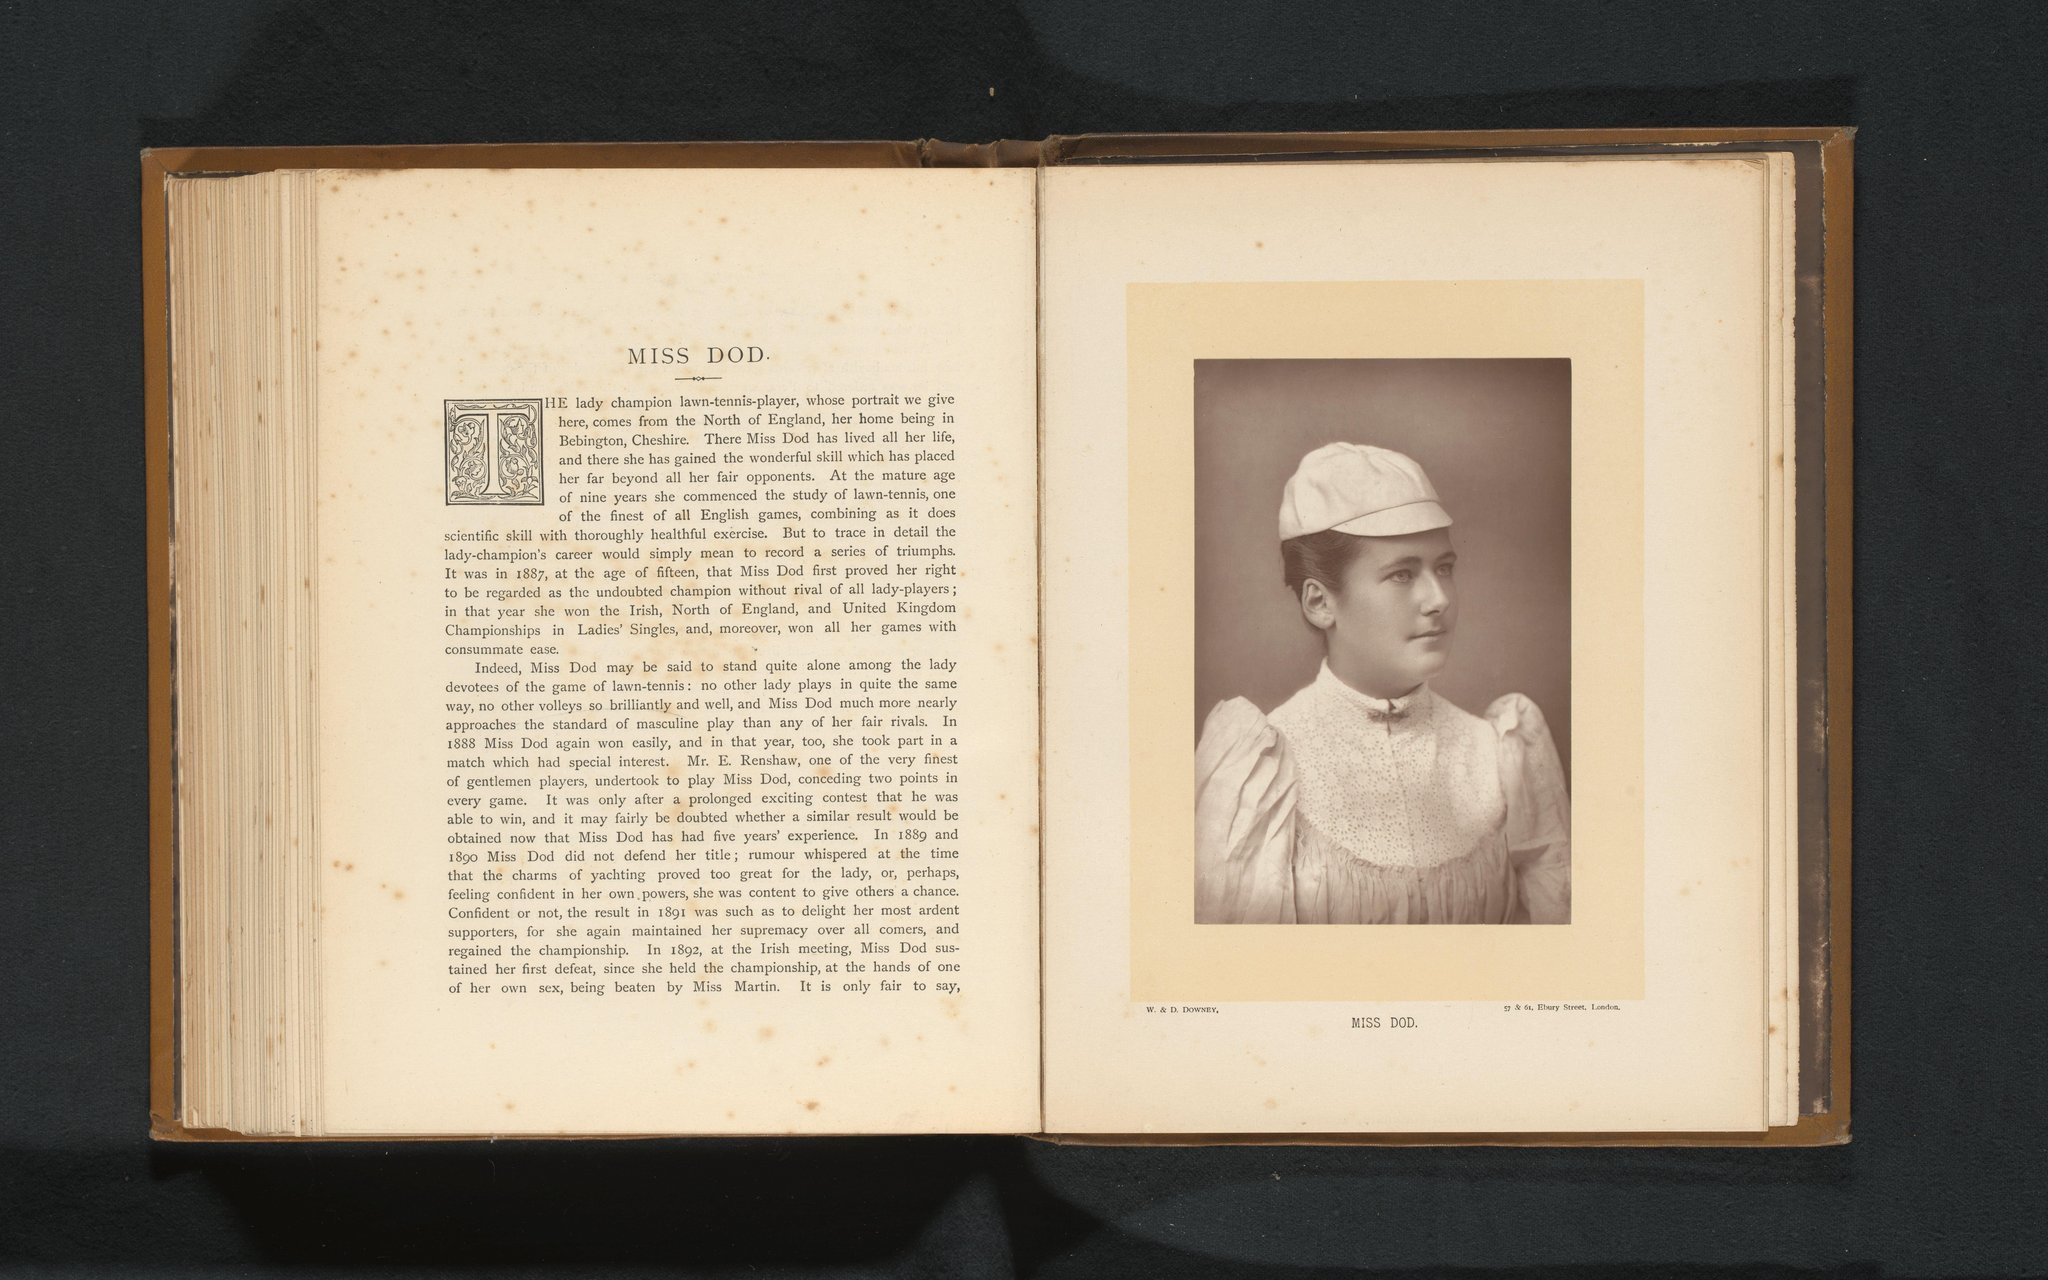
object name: photomechanical print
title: Miss Dod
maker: Anonymous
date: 1882-1892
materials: paper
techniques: woodburytype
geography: london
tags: tennis, lawn-tennis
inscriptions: inscription: ‘57 & 61, Elbury Street, London.’